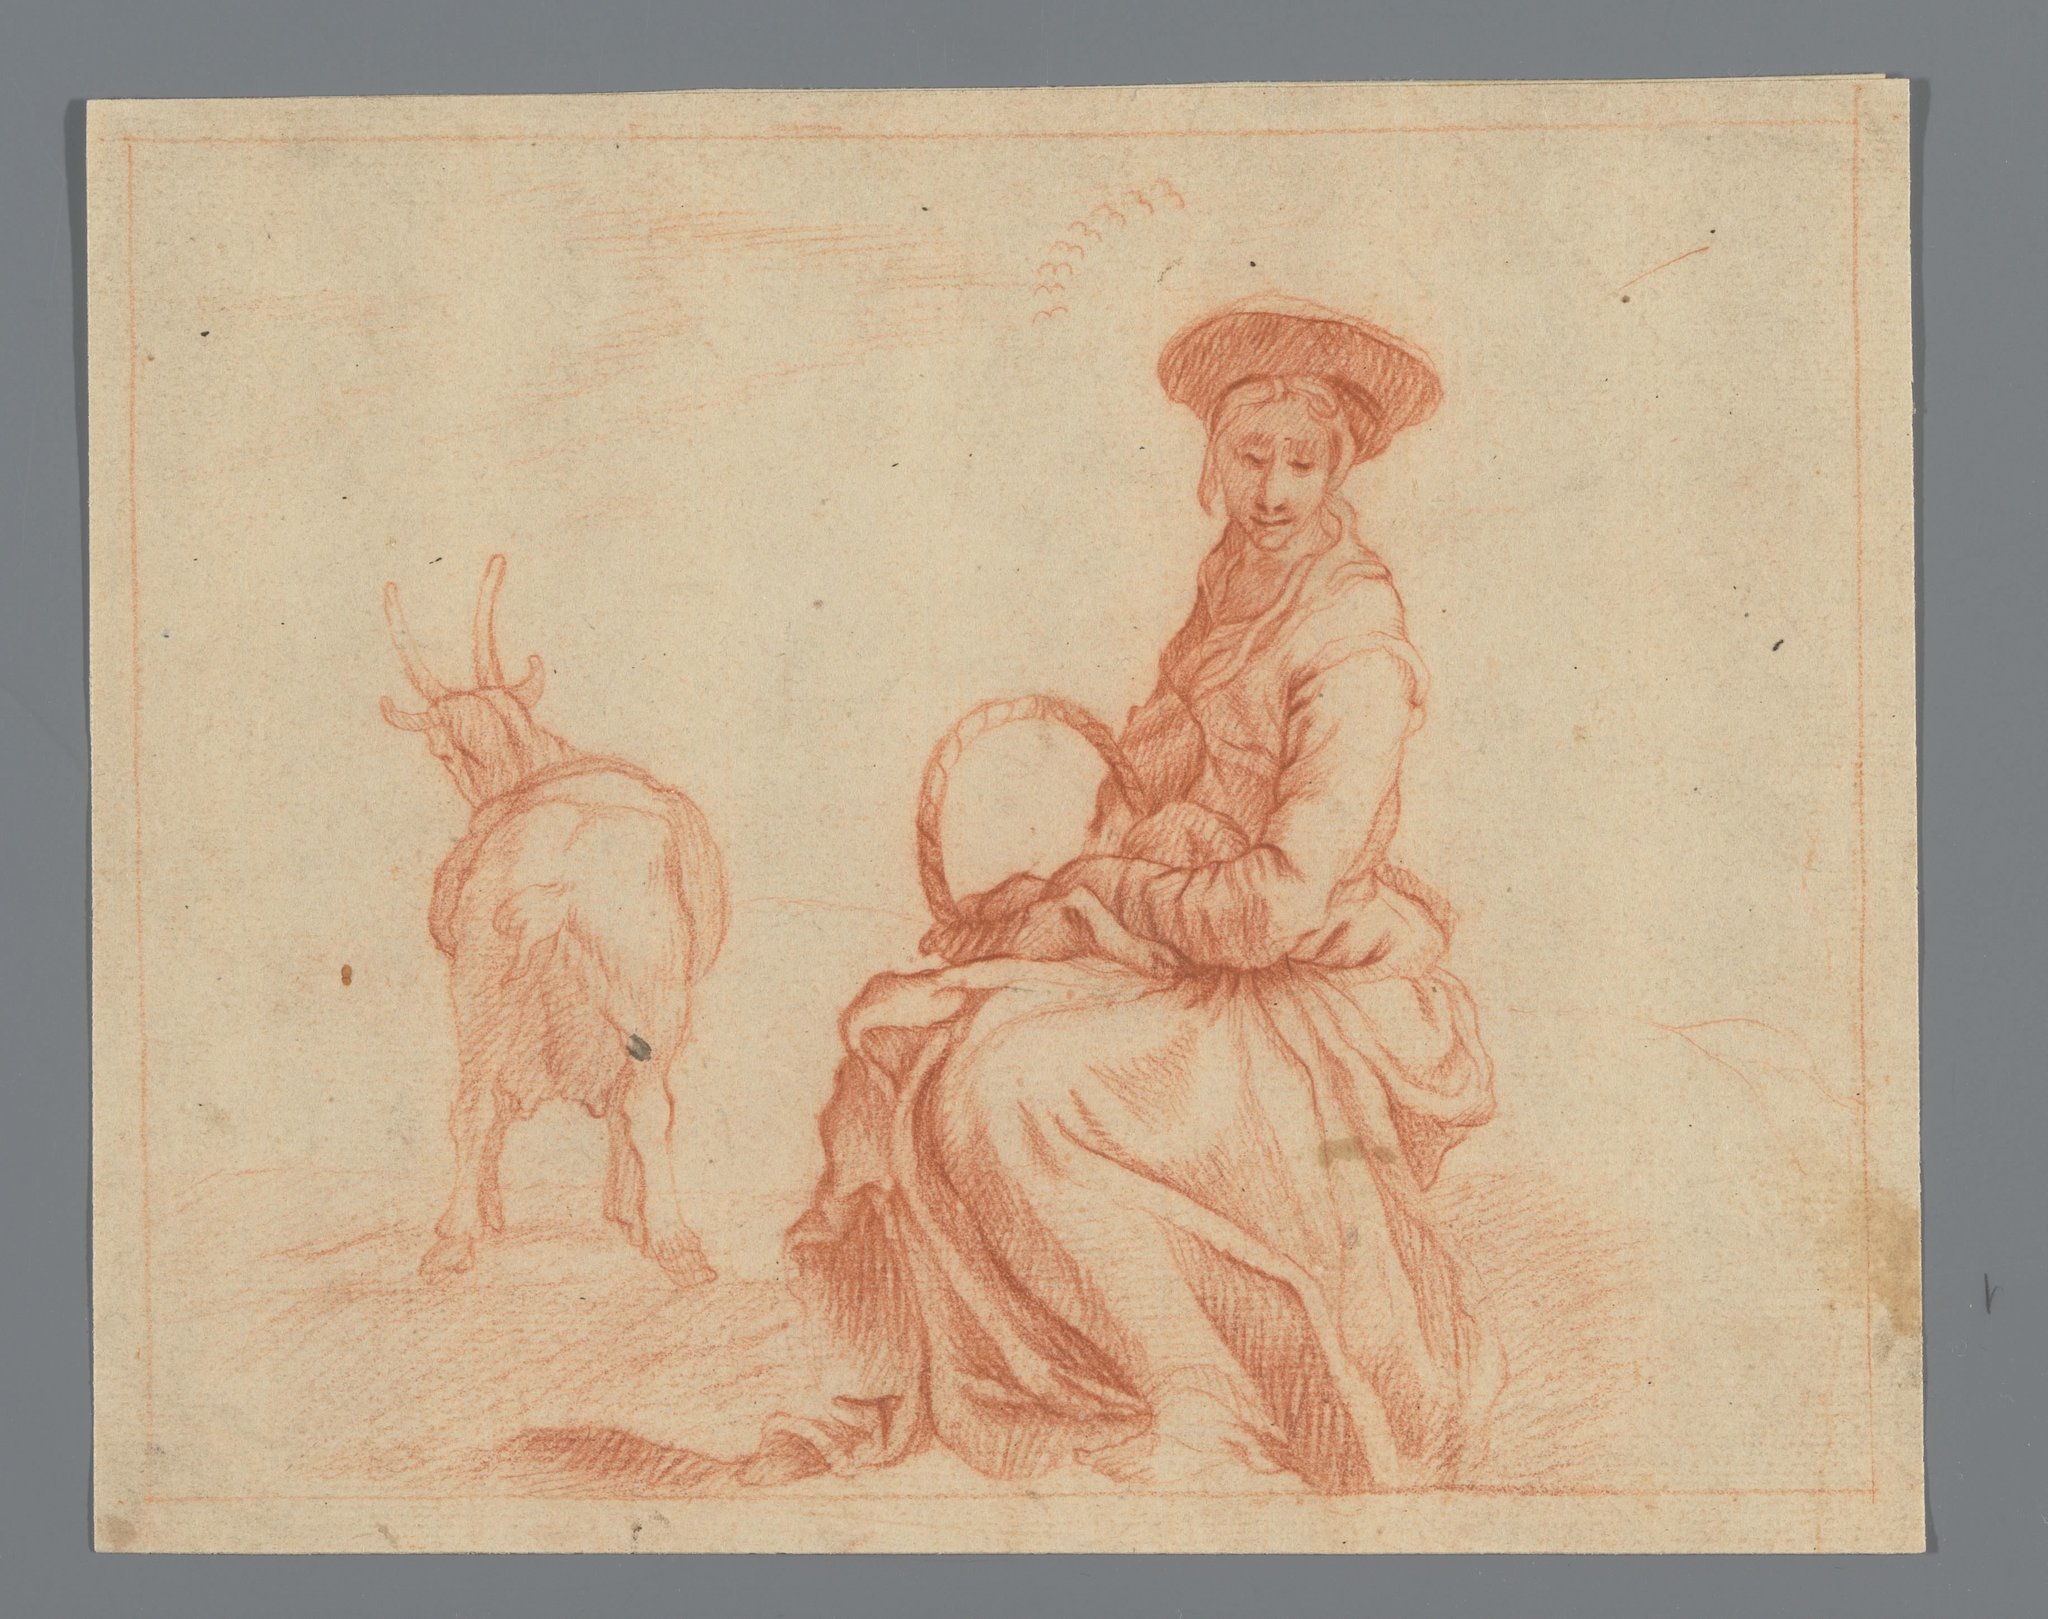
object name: drawing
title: Zittende herderin met geit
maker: Anonymous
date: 1700-1800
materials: chalk, paper